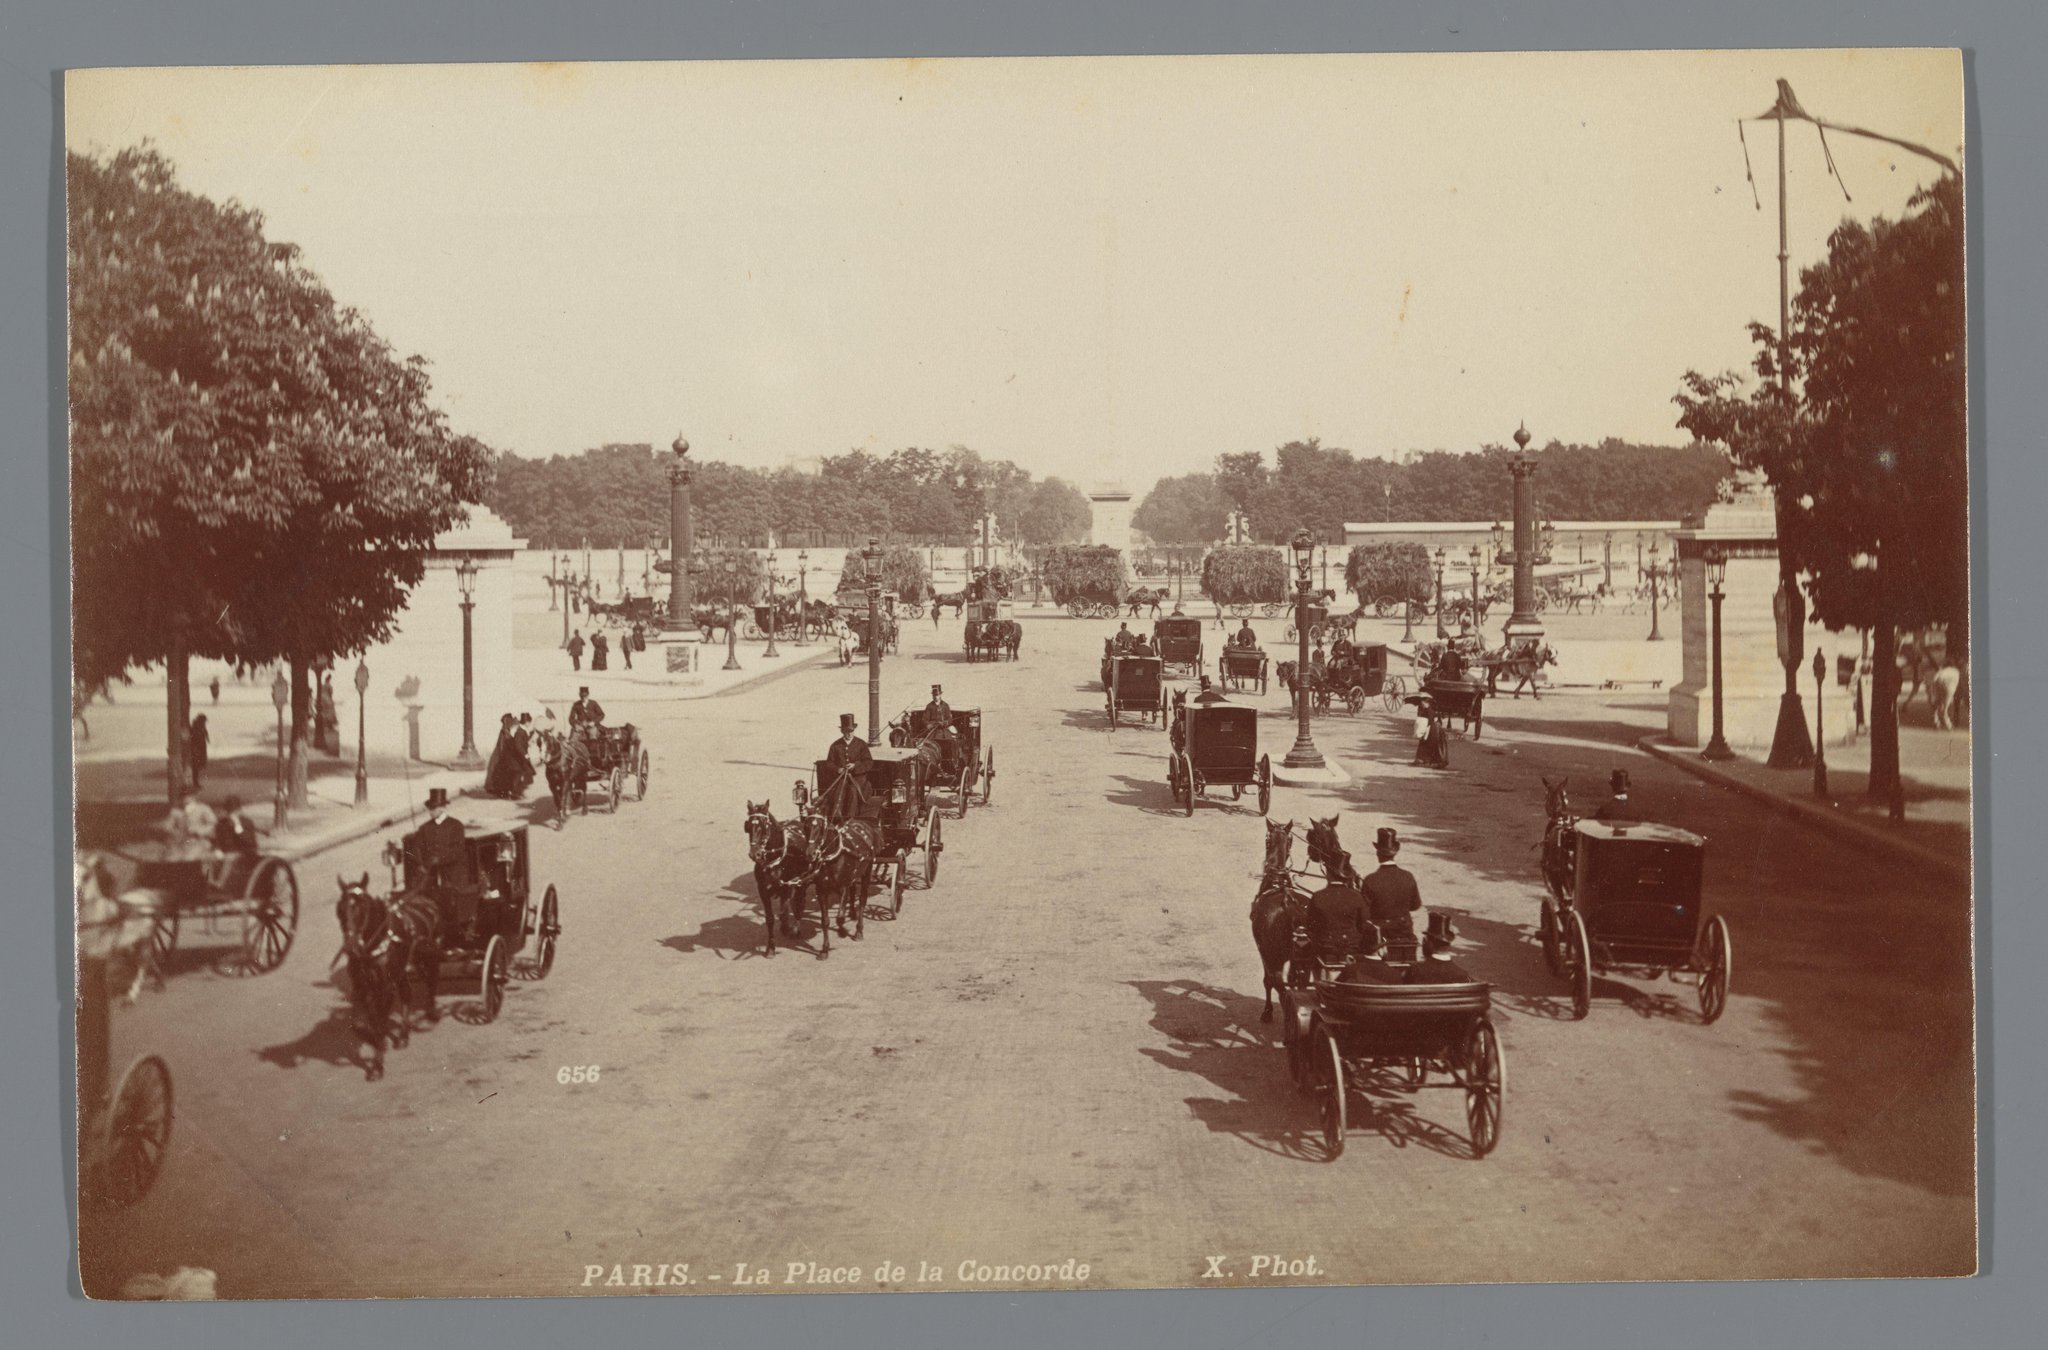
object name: photograph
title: Rijtuigen op Place de la Concorde te Parijs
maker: f. hélaine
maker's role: fotograaf, handelaar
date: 1887-1900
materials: paper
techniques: albumen print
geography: paris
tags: square, place, circus, etc., four-wheeled vehicle drawn by two animals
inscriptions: stamp: ‘F. Hélaine/ 214, Rue de Rivoli, 214/ Paris’, number: ‘217’, number: ‘656’